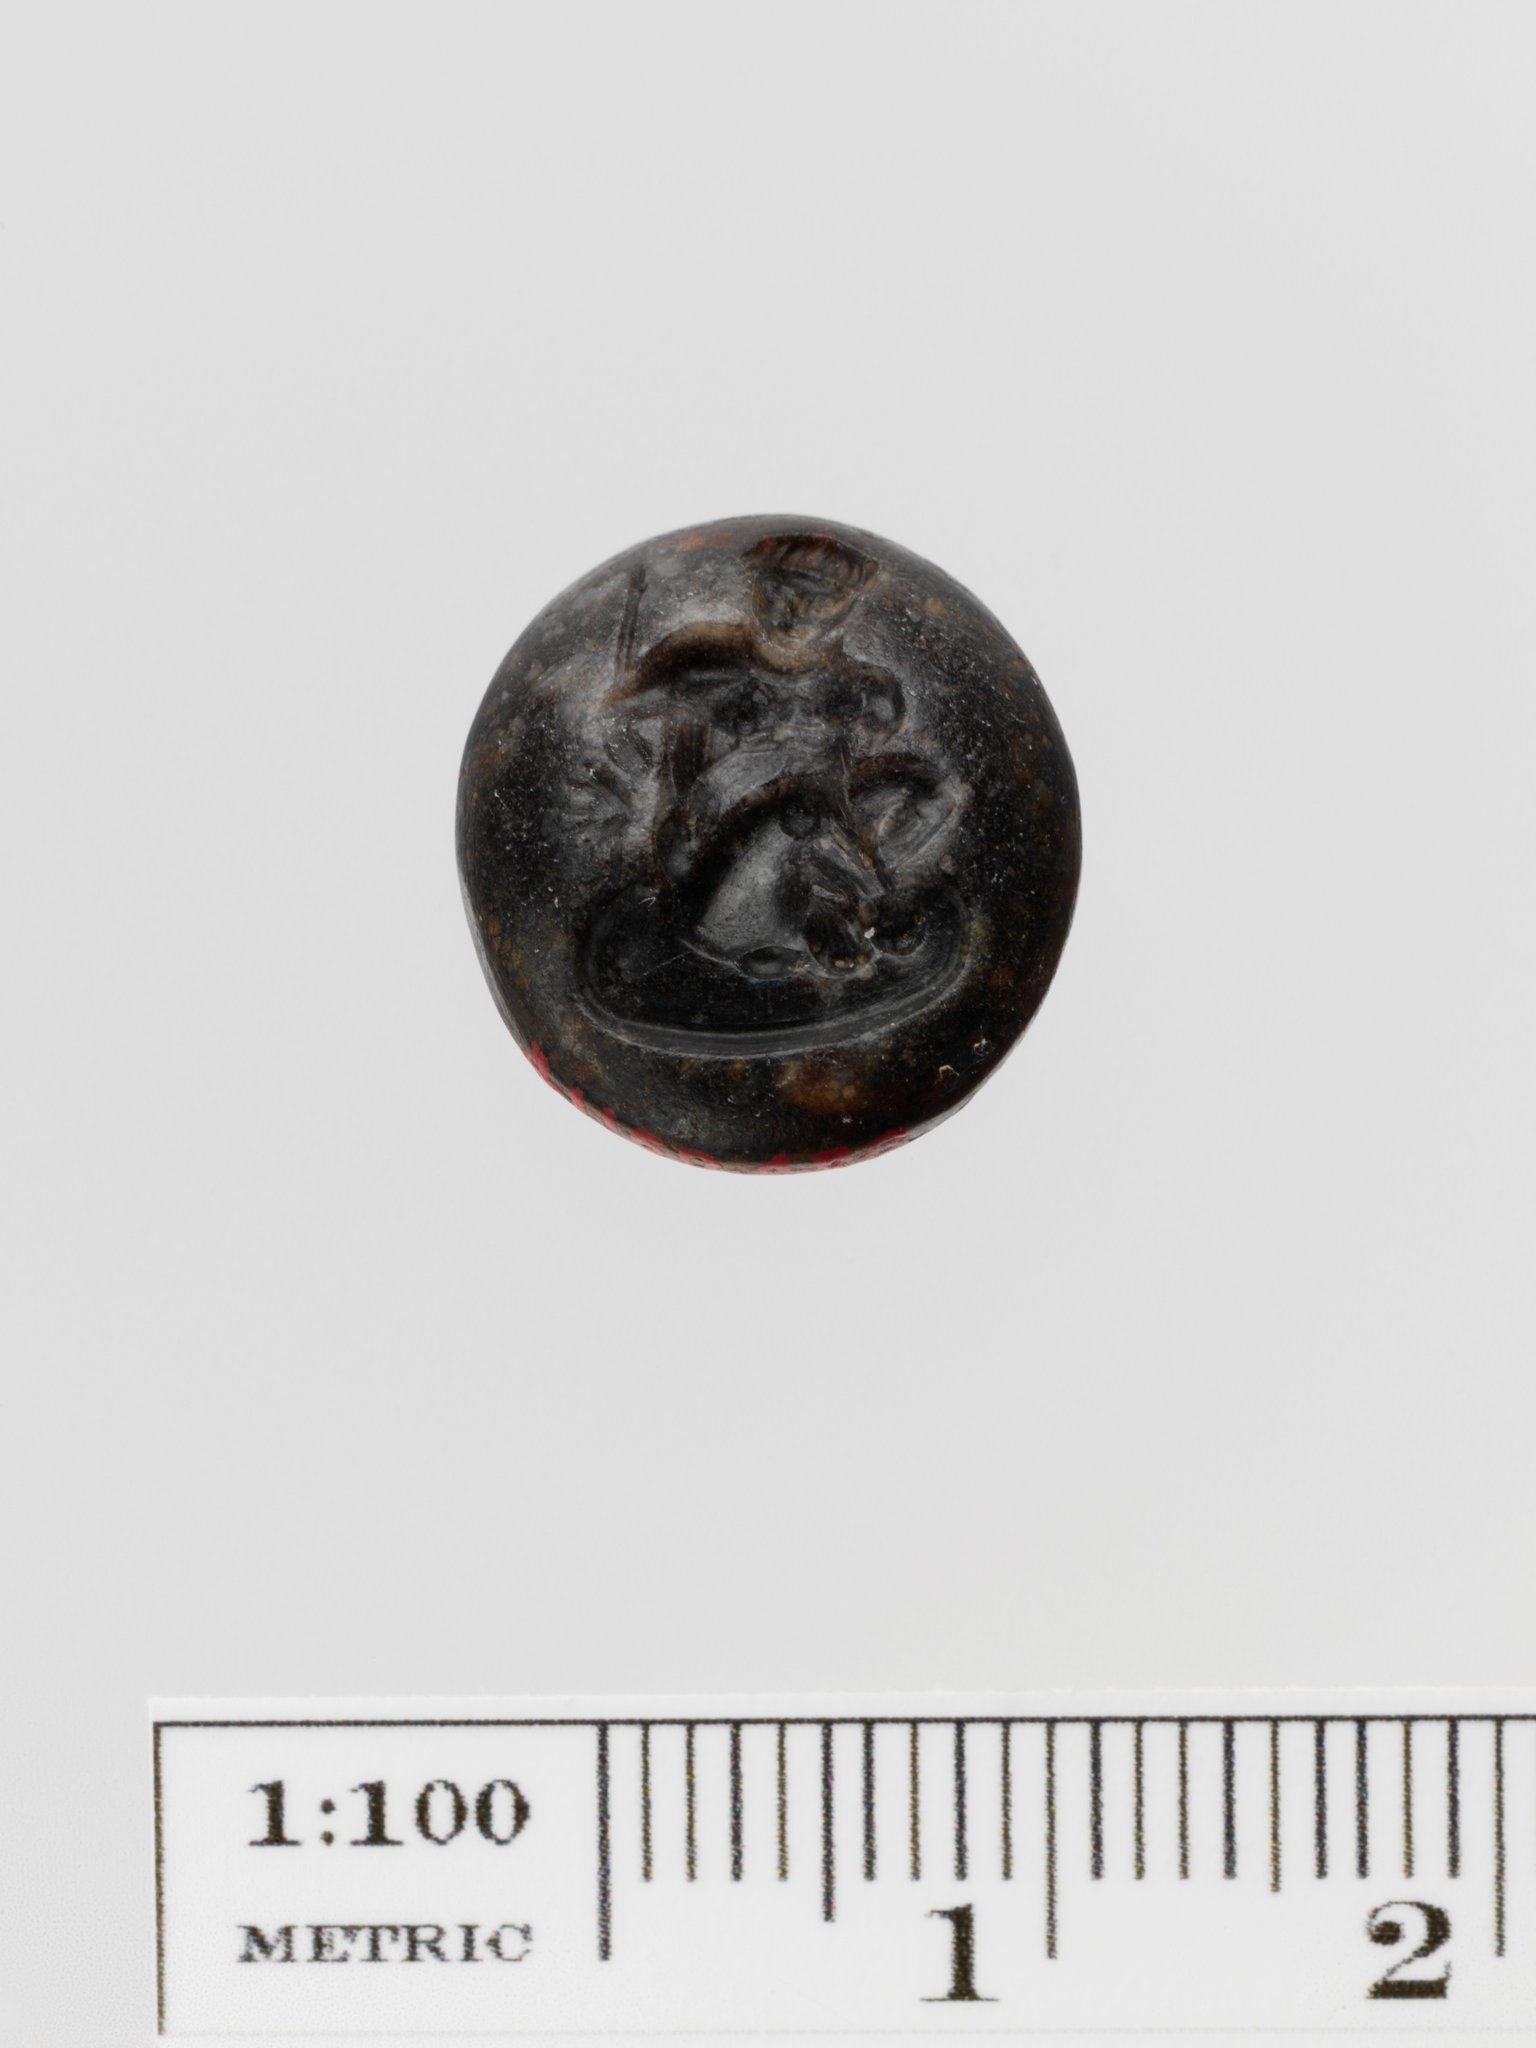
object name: intaglio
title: Agate ring stone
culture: italic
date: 300-101 BCE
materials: stone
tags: human figures